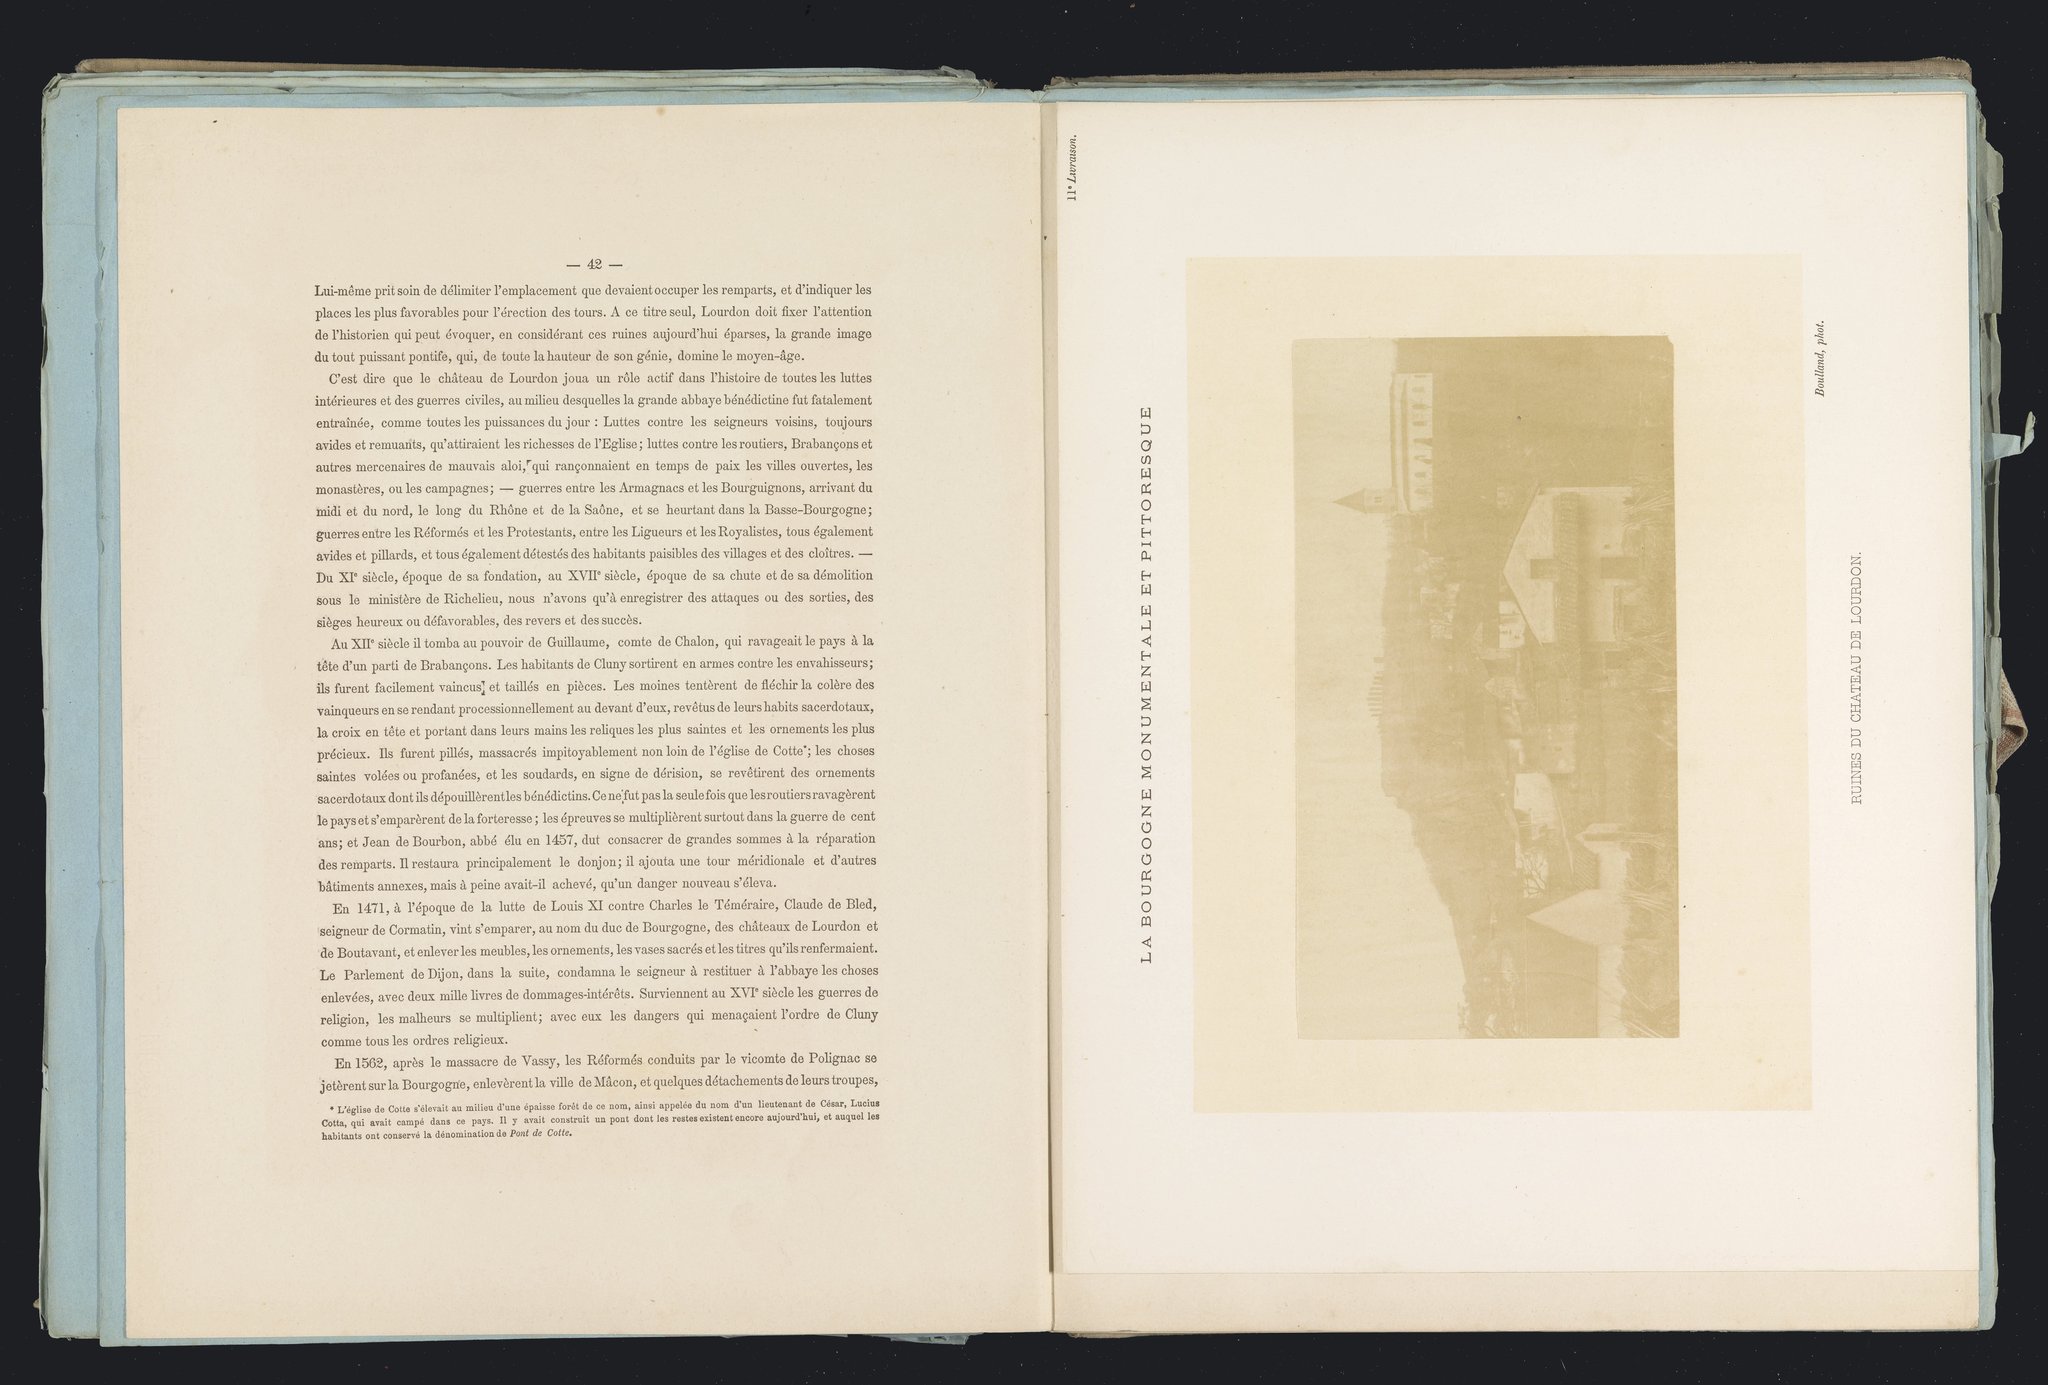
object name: page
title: Gezicht op Lournand met midden boven de kasteelruïne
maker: alfred boulland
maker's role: fotograaf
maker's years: 1814-1887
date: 1850-1873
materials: cardboard, photographic support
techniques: albumen print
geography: lournand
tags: prospect of village, silhouette of village, ruin of a dwelling, house, castle, etc.